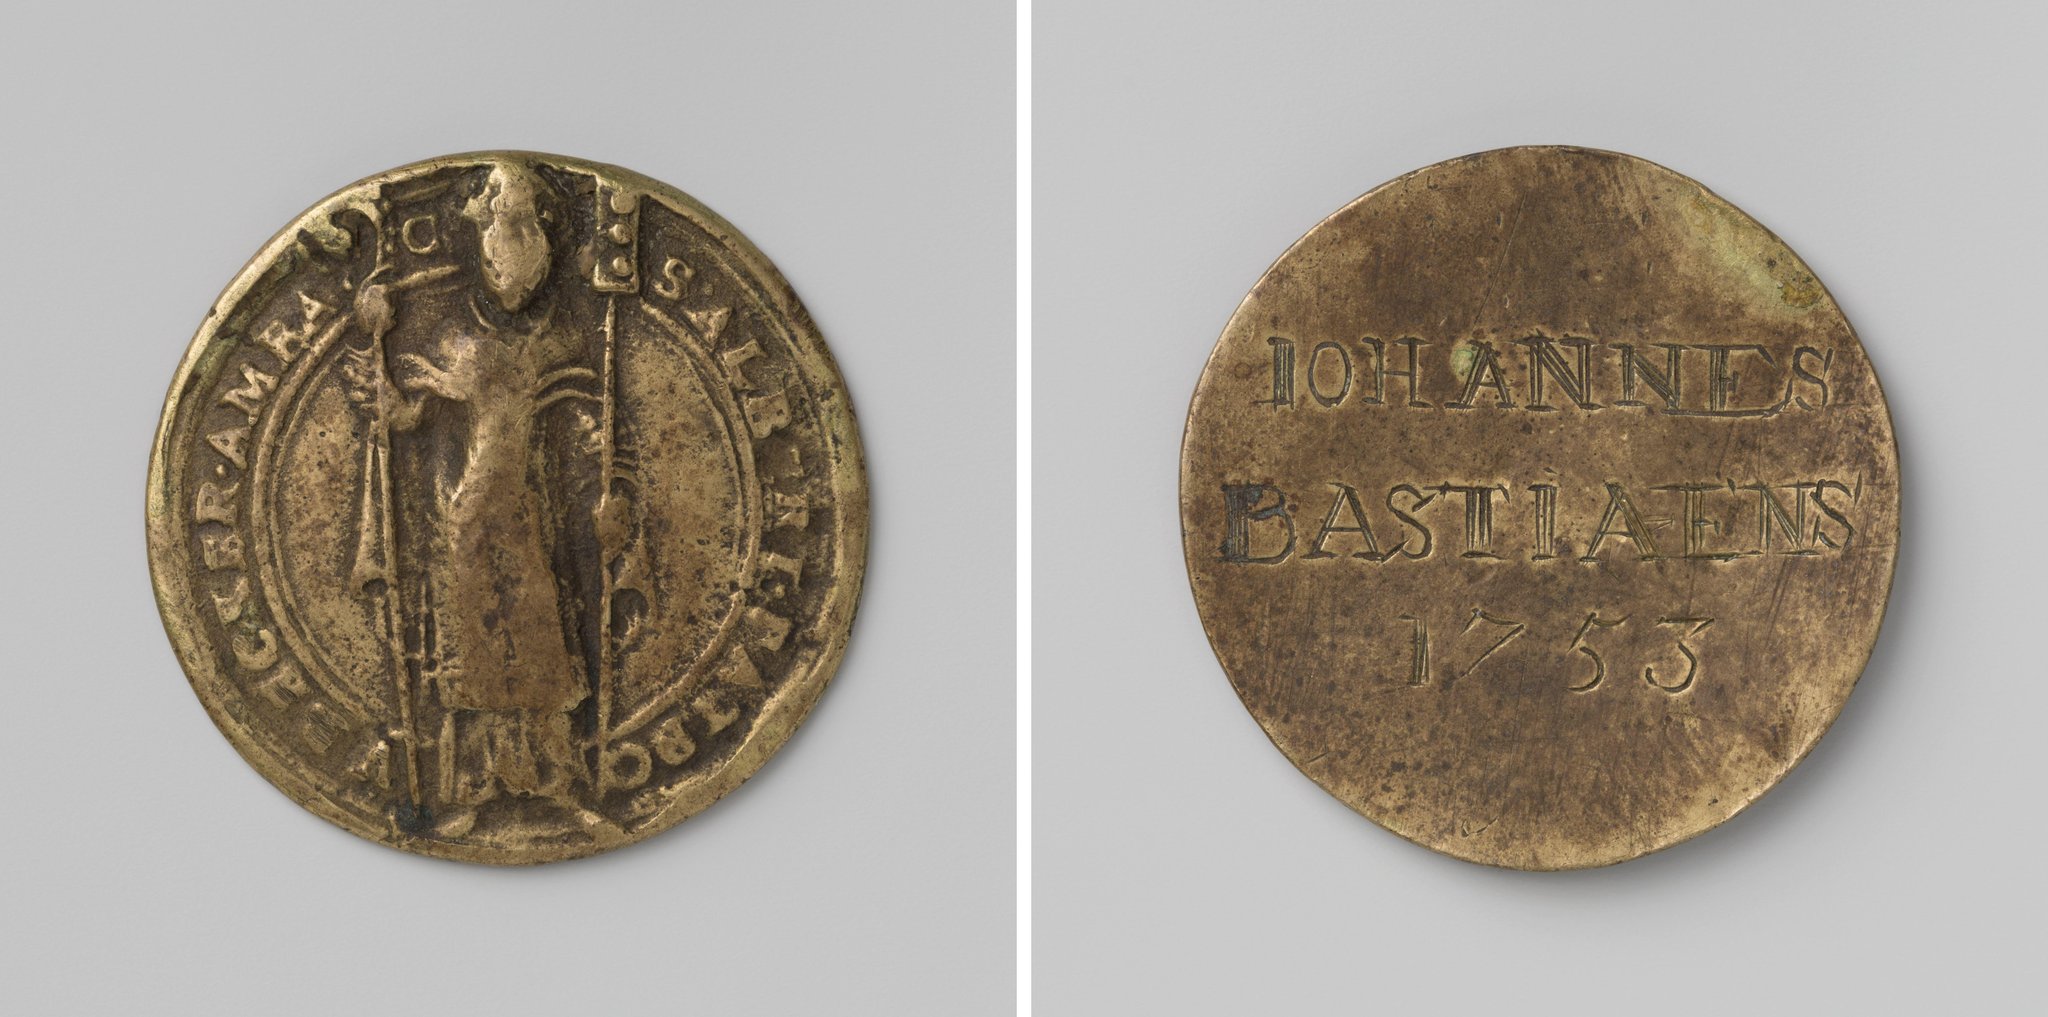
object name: medal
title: Bakkersgilde van Maastricht, gildepenning van Johannes Bastiaens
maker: Anonymous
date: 1753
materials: brass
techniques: casting, engraving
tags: maastricht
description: Messing penning. Voorzijde: St. Albert met mijter op hoofd houdt in rechterhand een staf en in linkerhand een bakkersinschuiver binnen omschrift. Keerzijde: opschrift